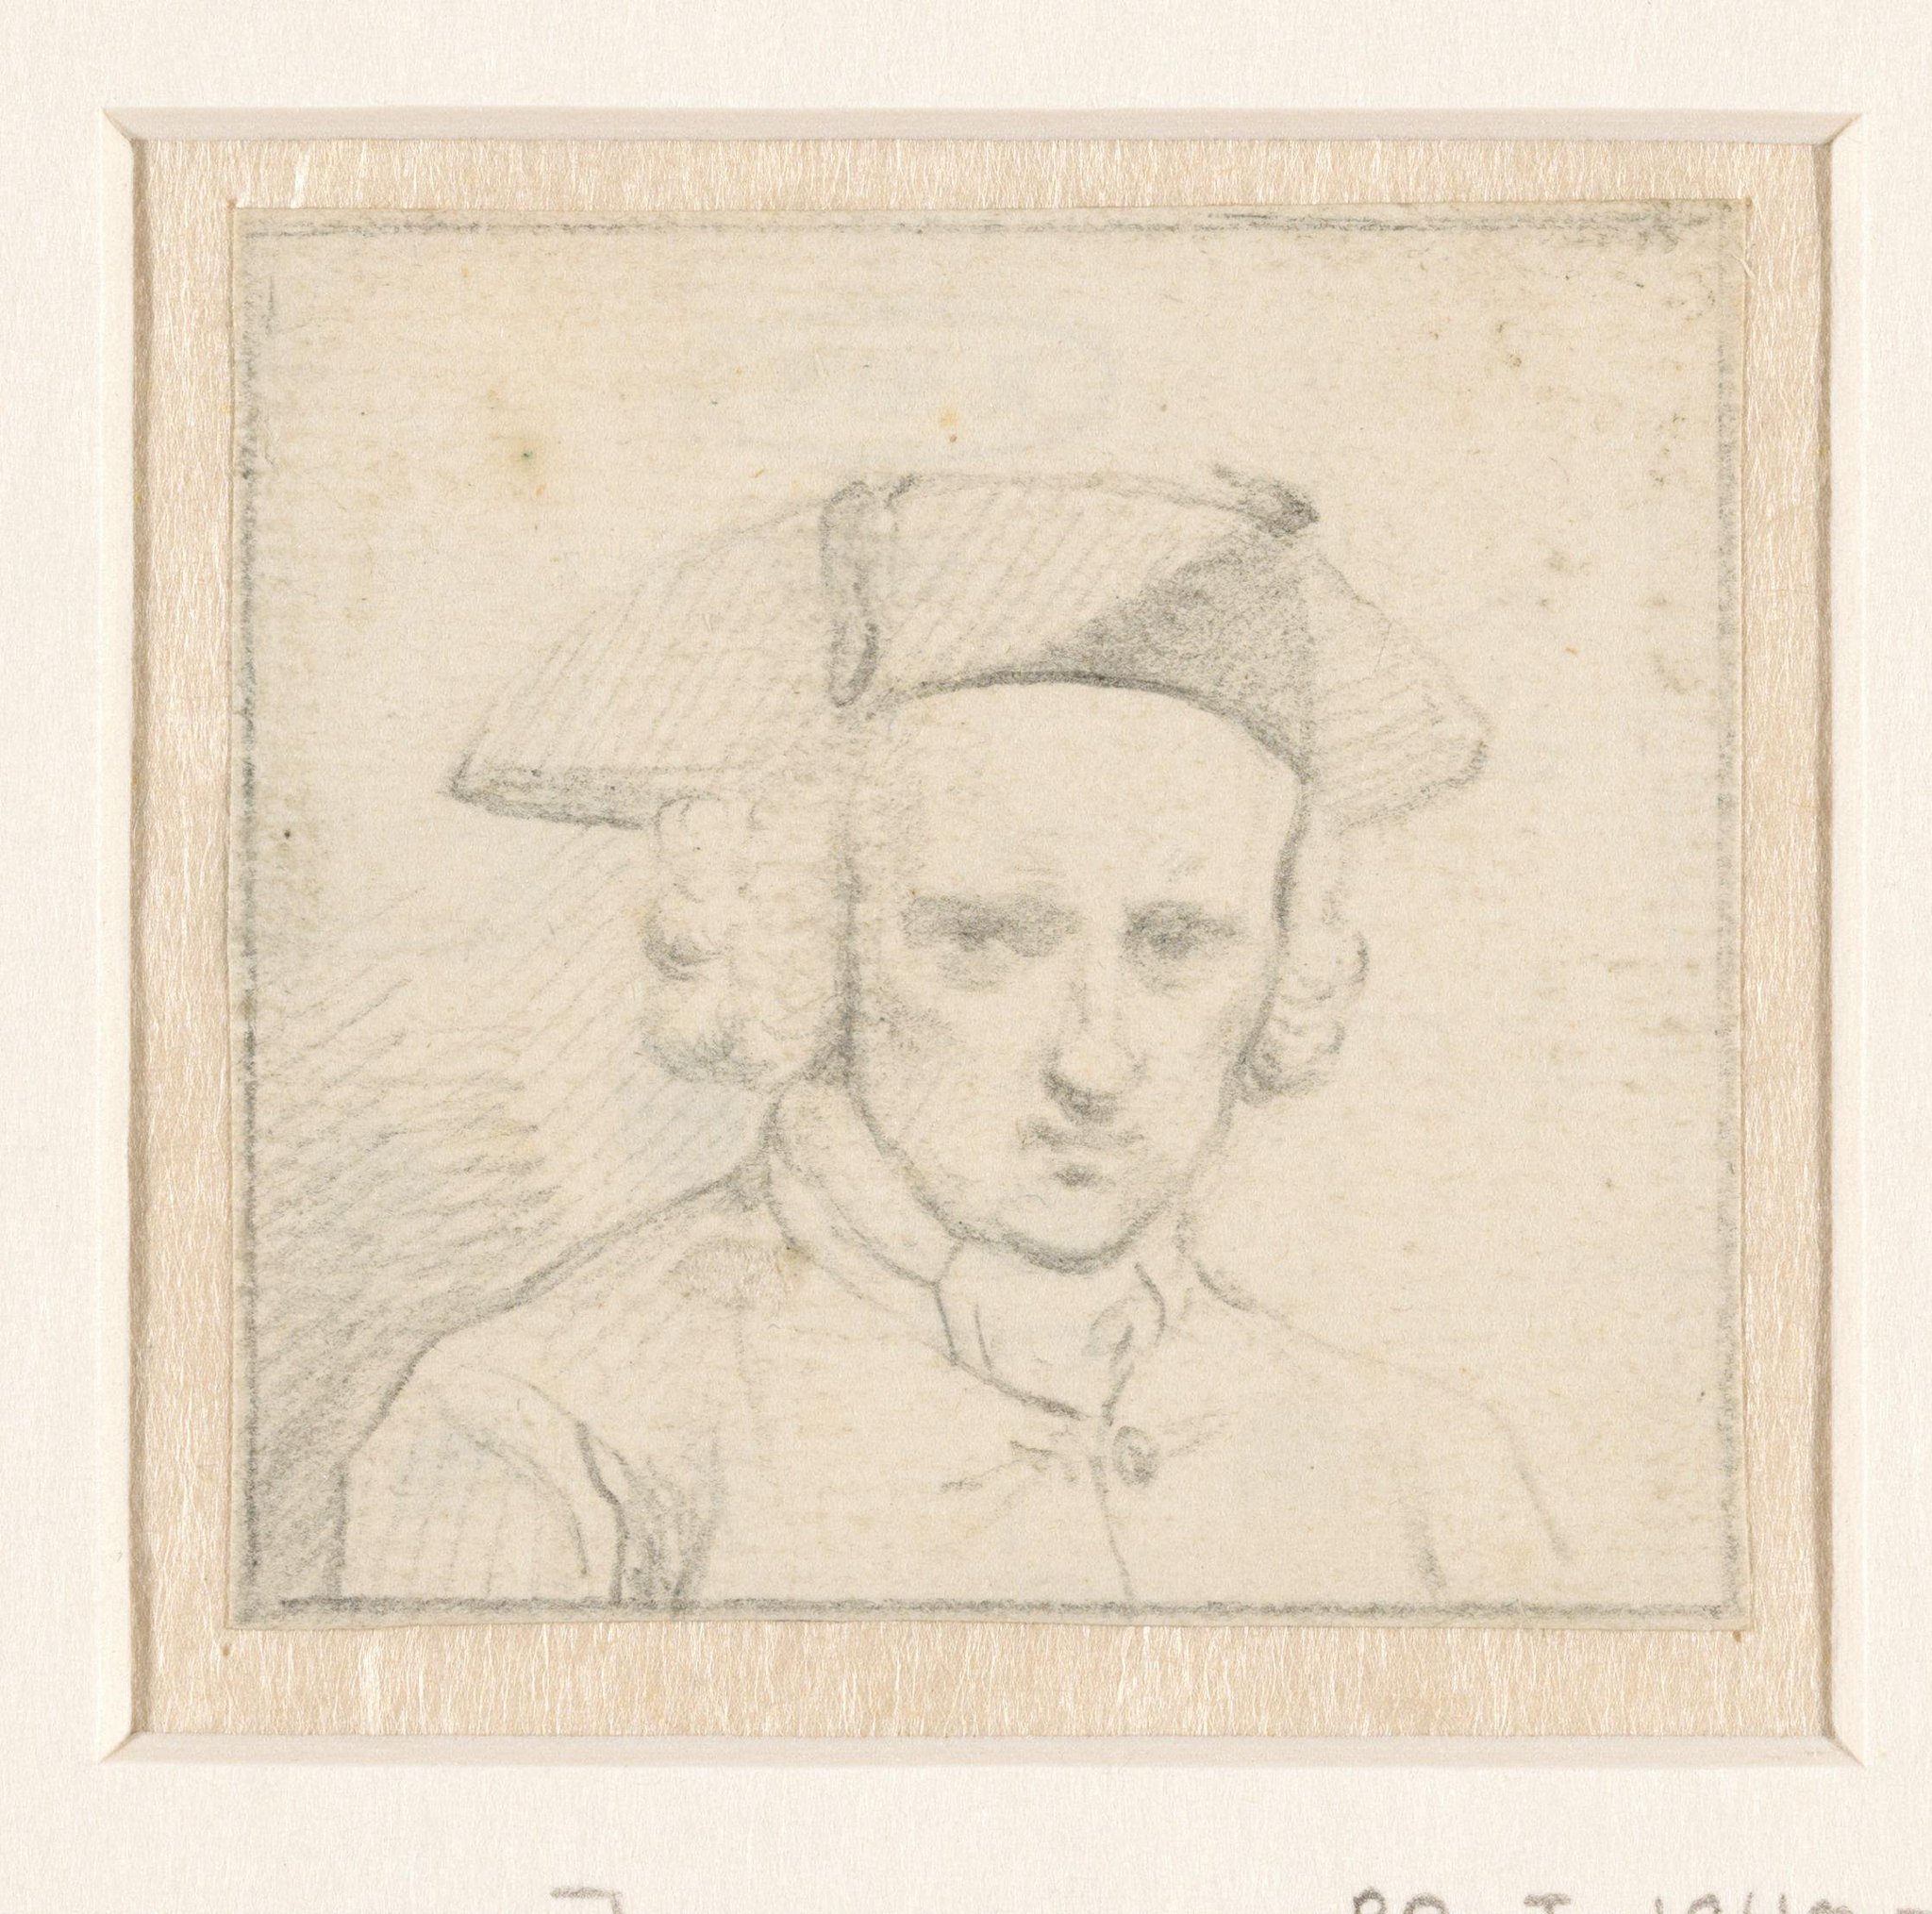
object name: drawing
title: Zelfportret van Jurriaan Andriessen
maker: jurriaan andriessen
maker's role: draughtsman, painter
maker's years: 1742-1819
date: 1755-1819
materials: paper, pencil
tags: amsterdam, painter, jurriaan andriessen, historical persons, portrait, self-portrait of painter, portrait, self-portrait of artist, portrait, self-portrait of draughtsman